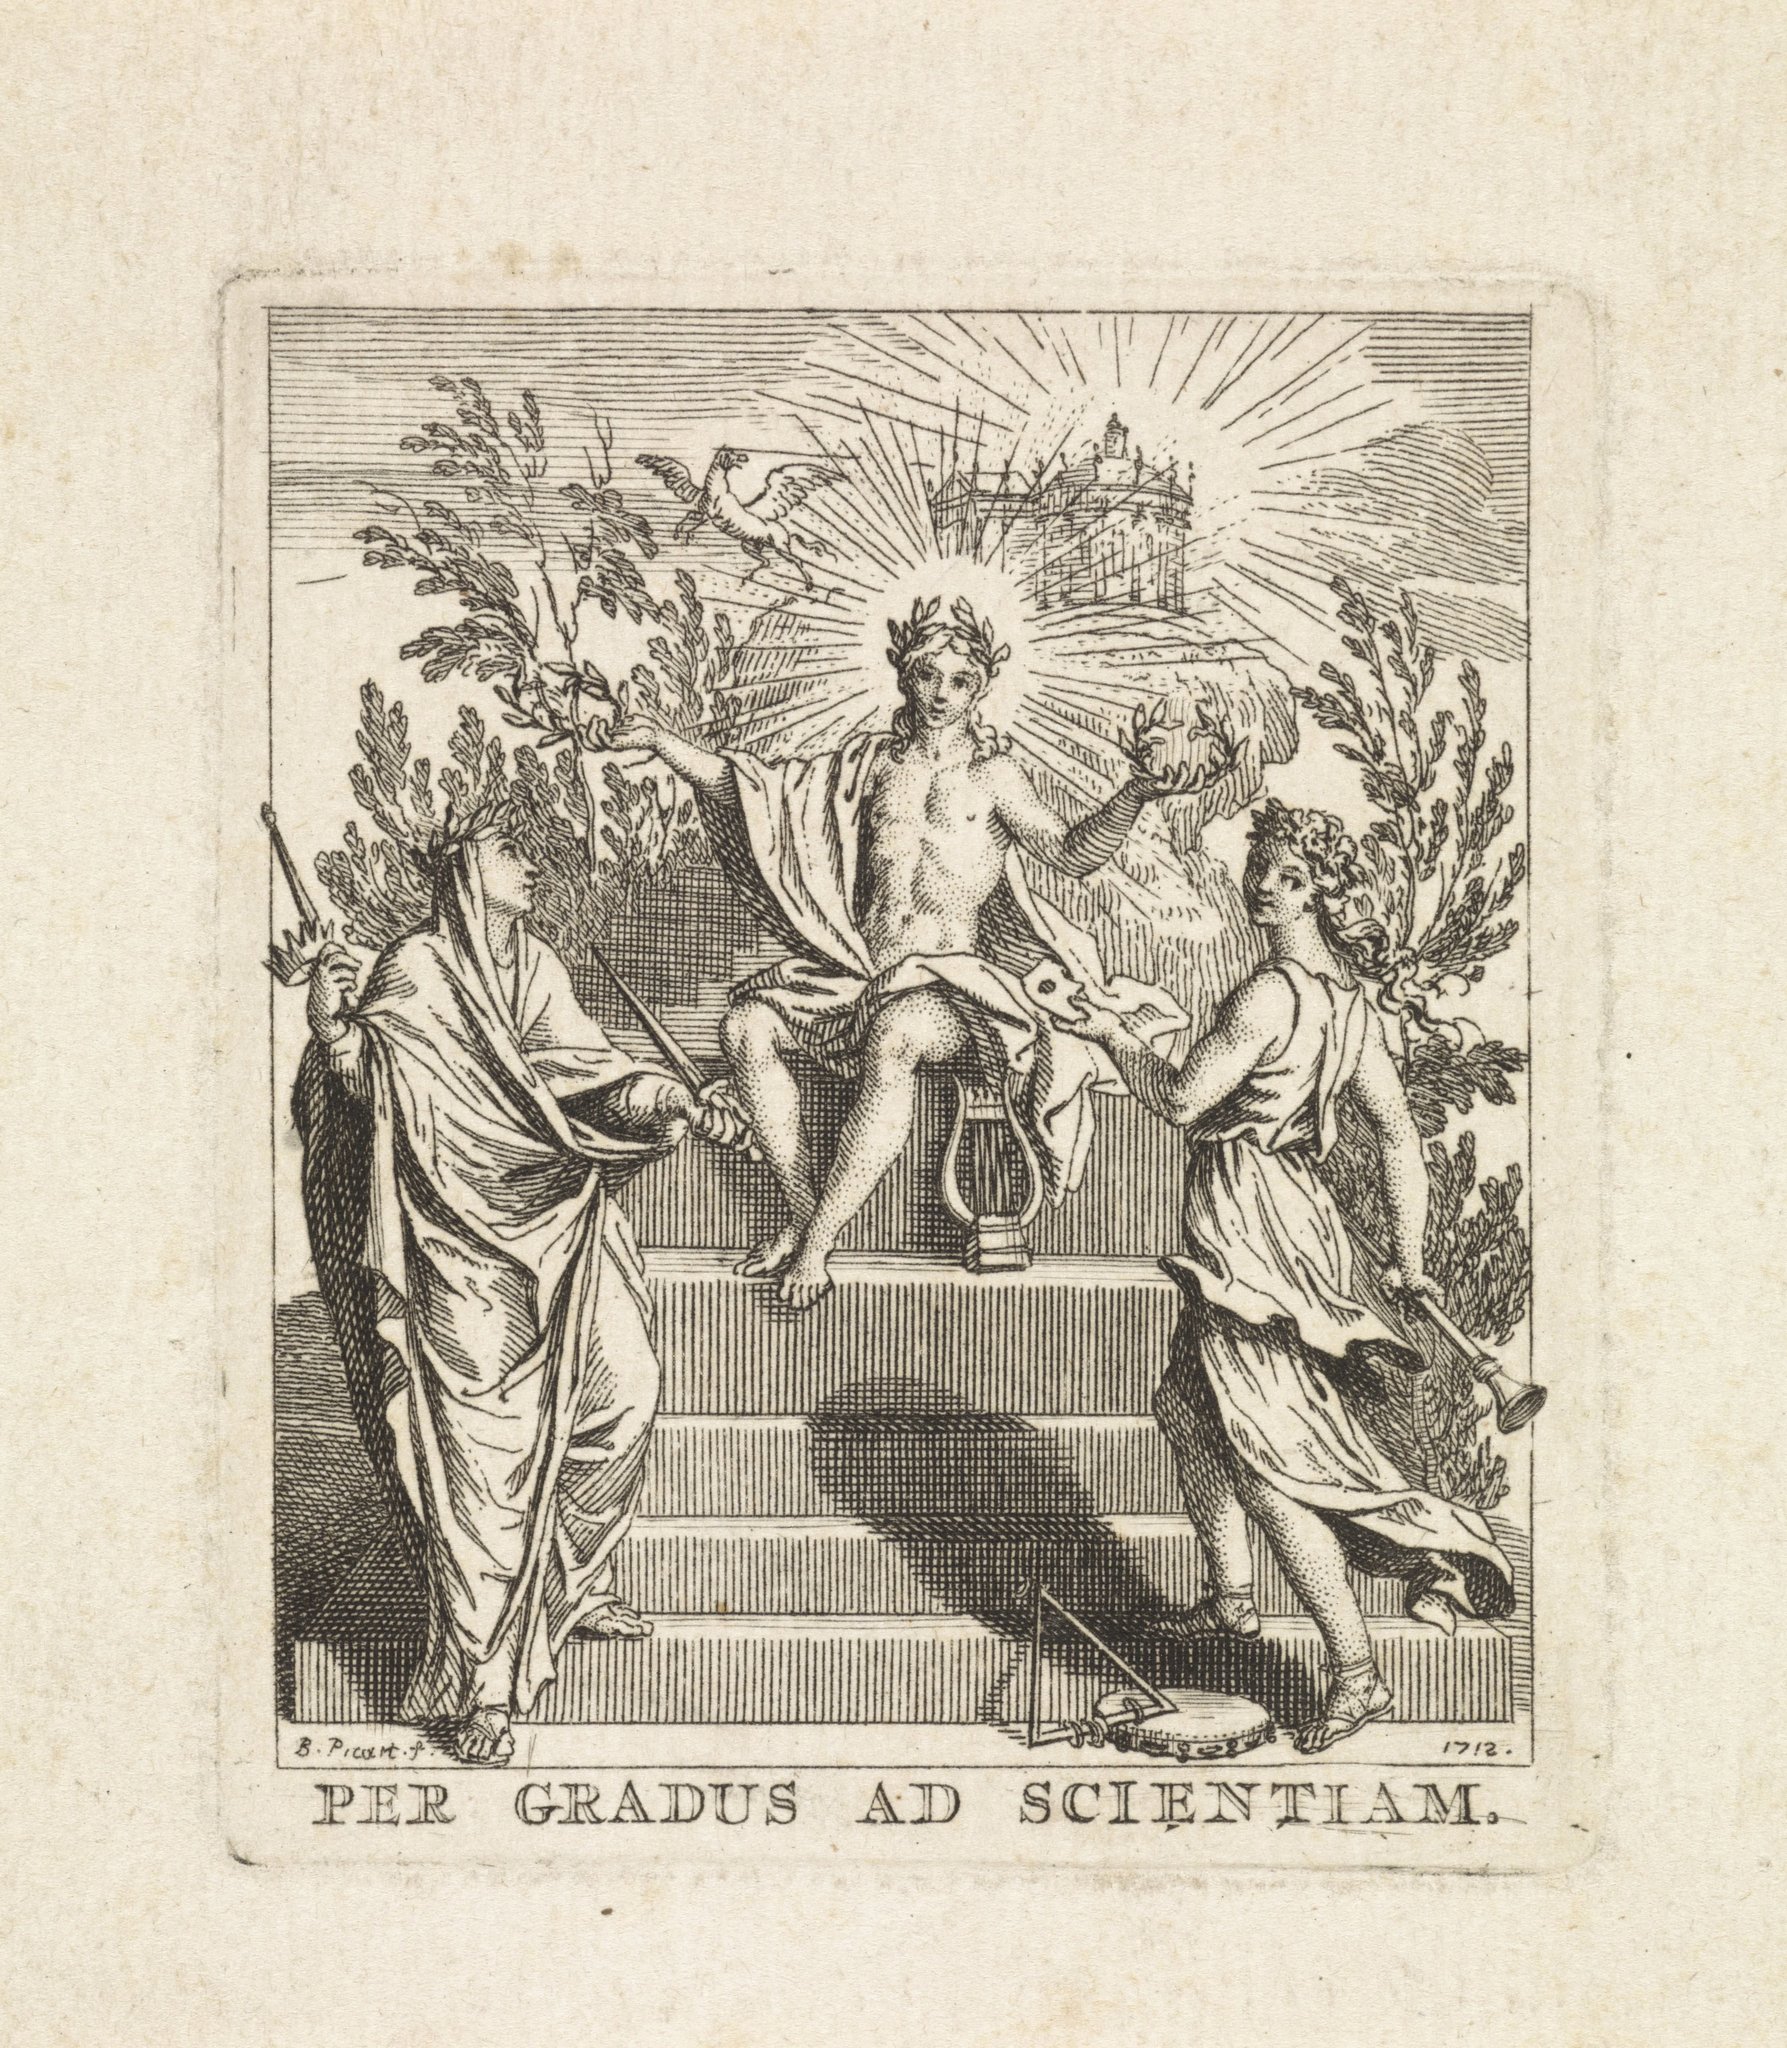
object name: print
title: Tronende Apollo met muzen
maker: bernard picart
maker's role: draughtsman, print maker, publisher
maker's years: 1673-1733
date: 1712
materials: paper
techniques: engraving, etching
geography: amsterdam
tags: (story of) apollo (phoebus), thalia (one of the muses); 'talia' (ripa), melpomene (one of the muses); 'melpomene' (ripa)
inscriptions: collector's mark: Lugt 2228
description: Tronende Apollo op de Parnassus met laurierkransen in de handen. Hij wordt geflankeerd door Melpomene, muze van het treurspel, en Thalia, muze van het blijspel. Onder de voorstelling het devies: Per Gradus Ad Scientiam.